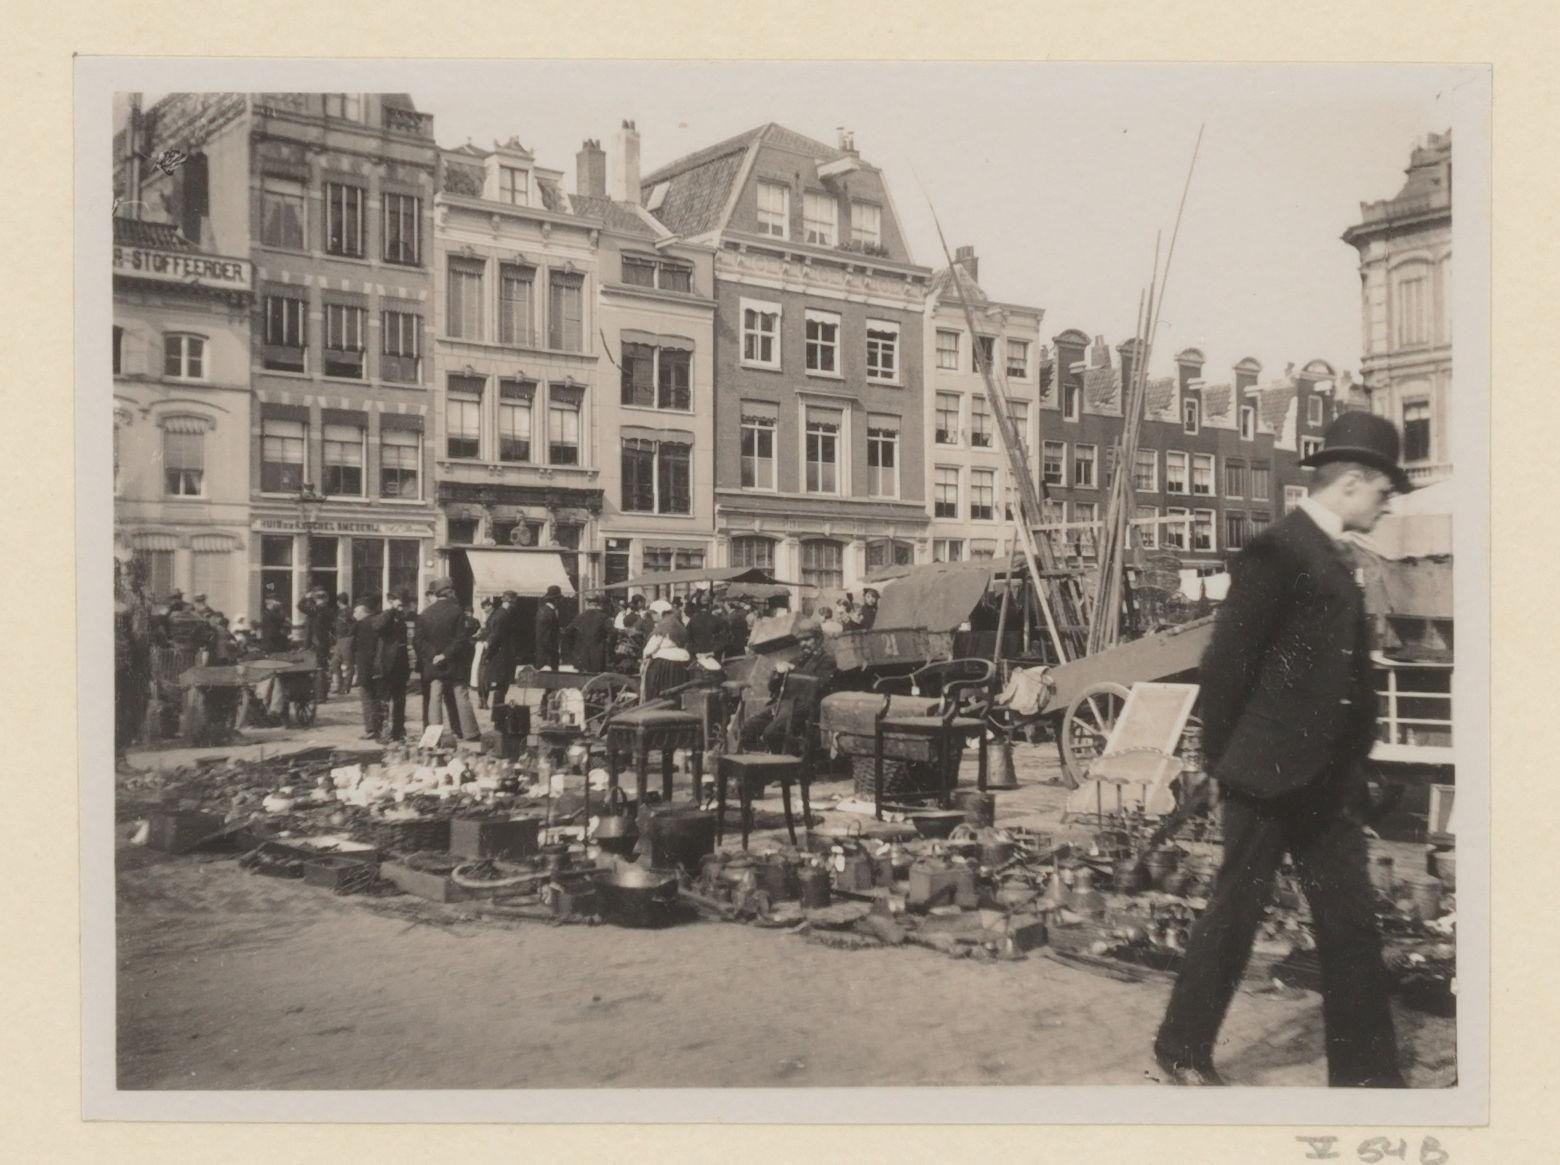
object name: photograph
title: Gezicht op de maandagmarkt op het Amstelveld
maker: Anonymous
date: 1880-1950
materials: paper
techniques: gelatin silver print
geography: amsterdam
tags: square, place, circus, etc., city-view in general; 'veduta', stall, booth (~ market), market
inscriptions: collector's mark: ‘5’ Lugt 1641b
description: Onderwerpsrubriek binnen de Atlas Amsterdam: Amstelgrachtje, Amstelkanaal (Noorder-), Amstelveld, Amstelstraat (Nieuwe), Annadwarsstraat, Anthoniebreestraat.